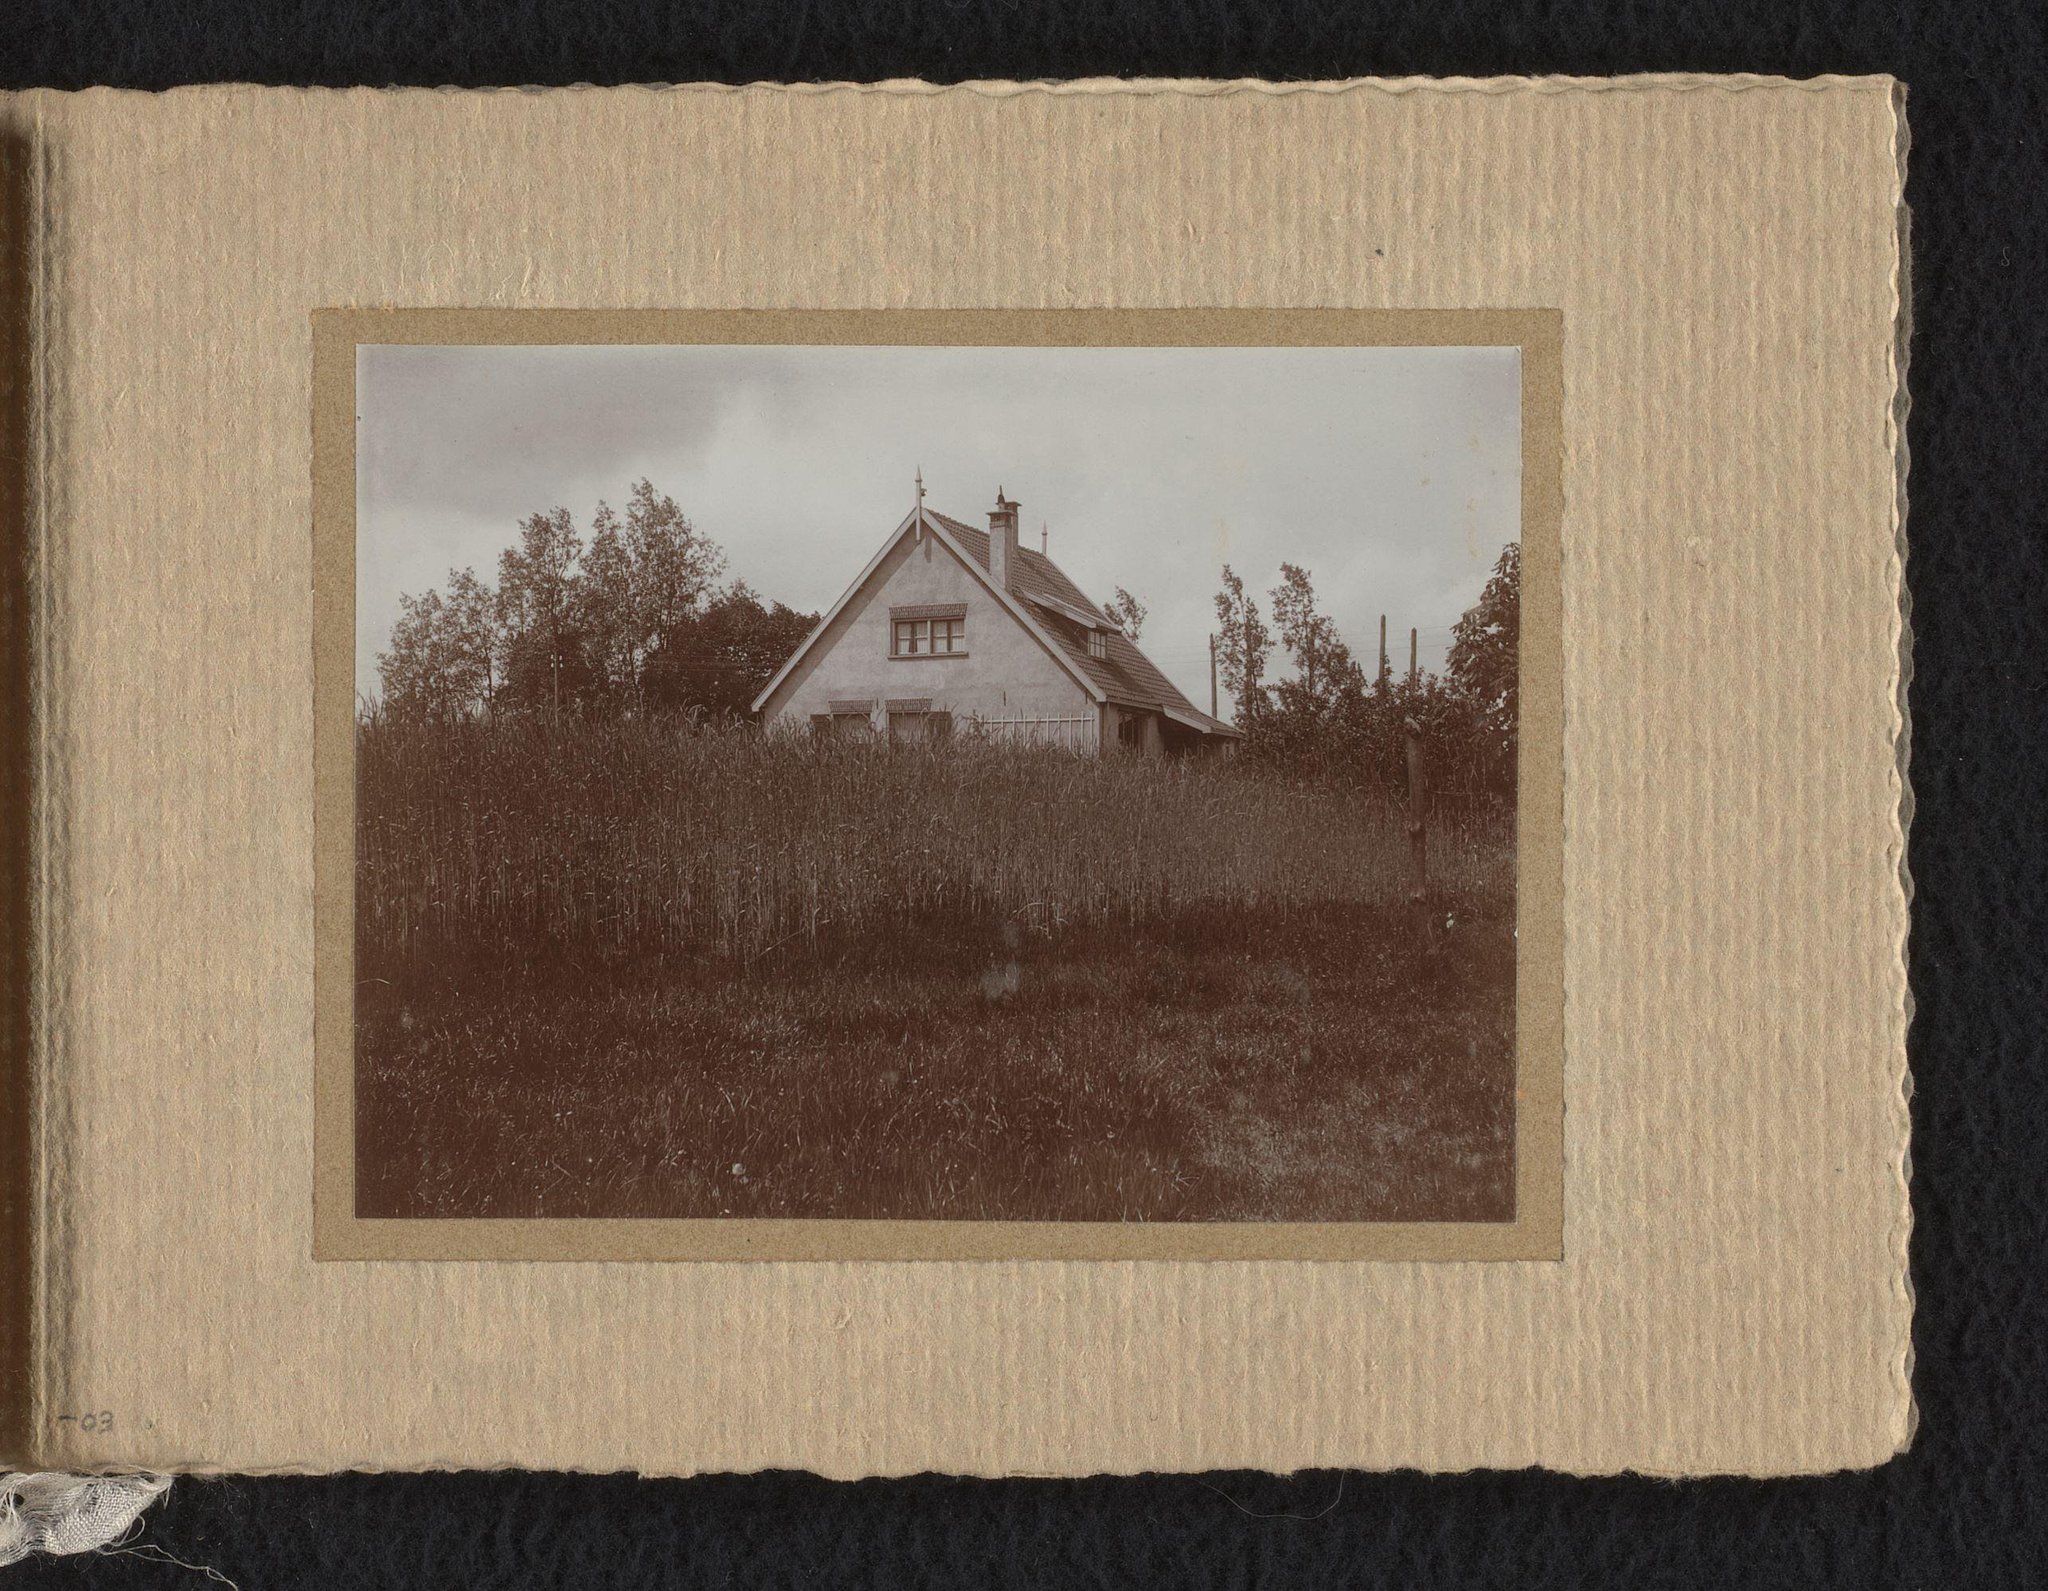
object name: photograph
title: Gezicht op het woonhuis en atelier van Cornelis van der Griendt in Laren, Noord-Holland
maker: cornelis van der griendt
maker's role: draughtsman, painter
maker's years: 1827-1918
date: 1895-1918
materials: paper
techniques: gelatin silver print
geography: laren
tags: delft, painter, draughtsman, cornelis van der griendt, villa